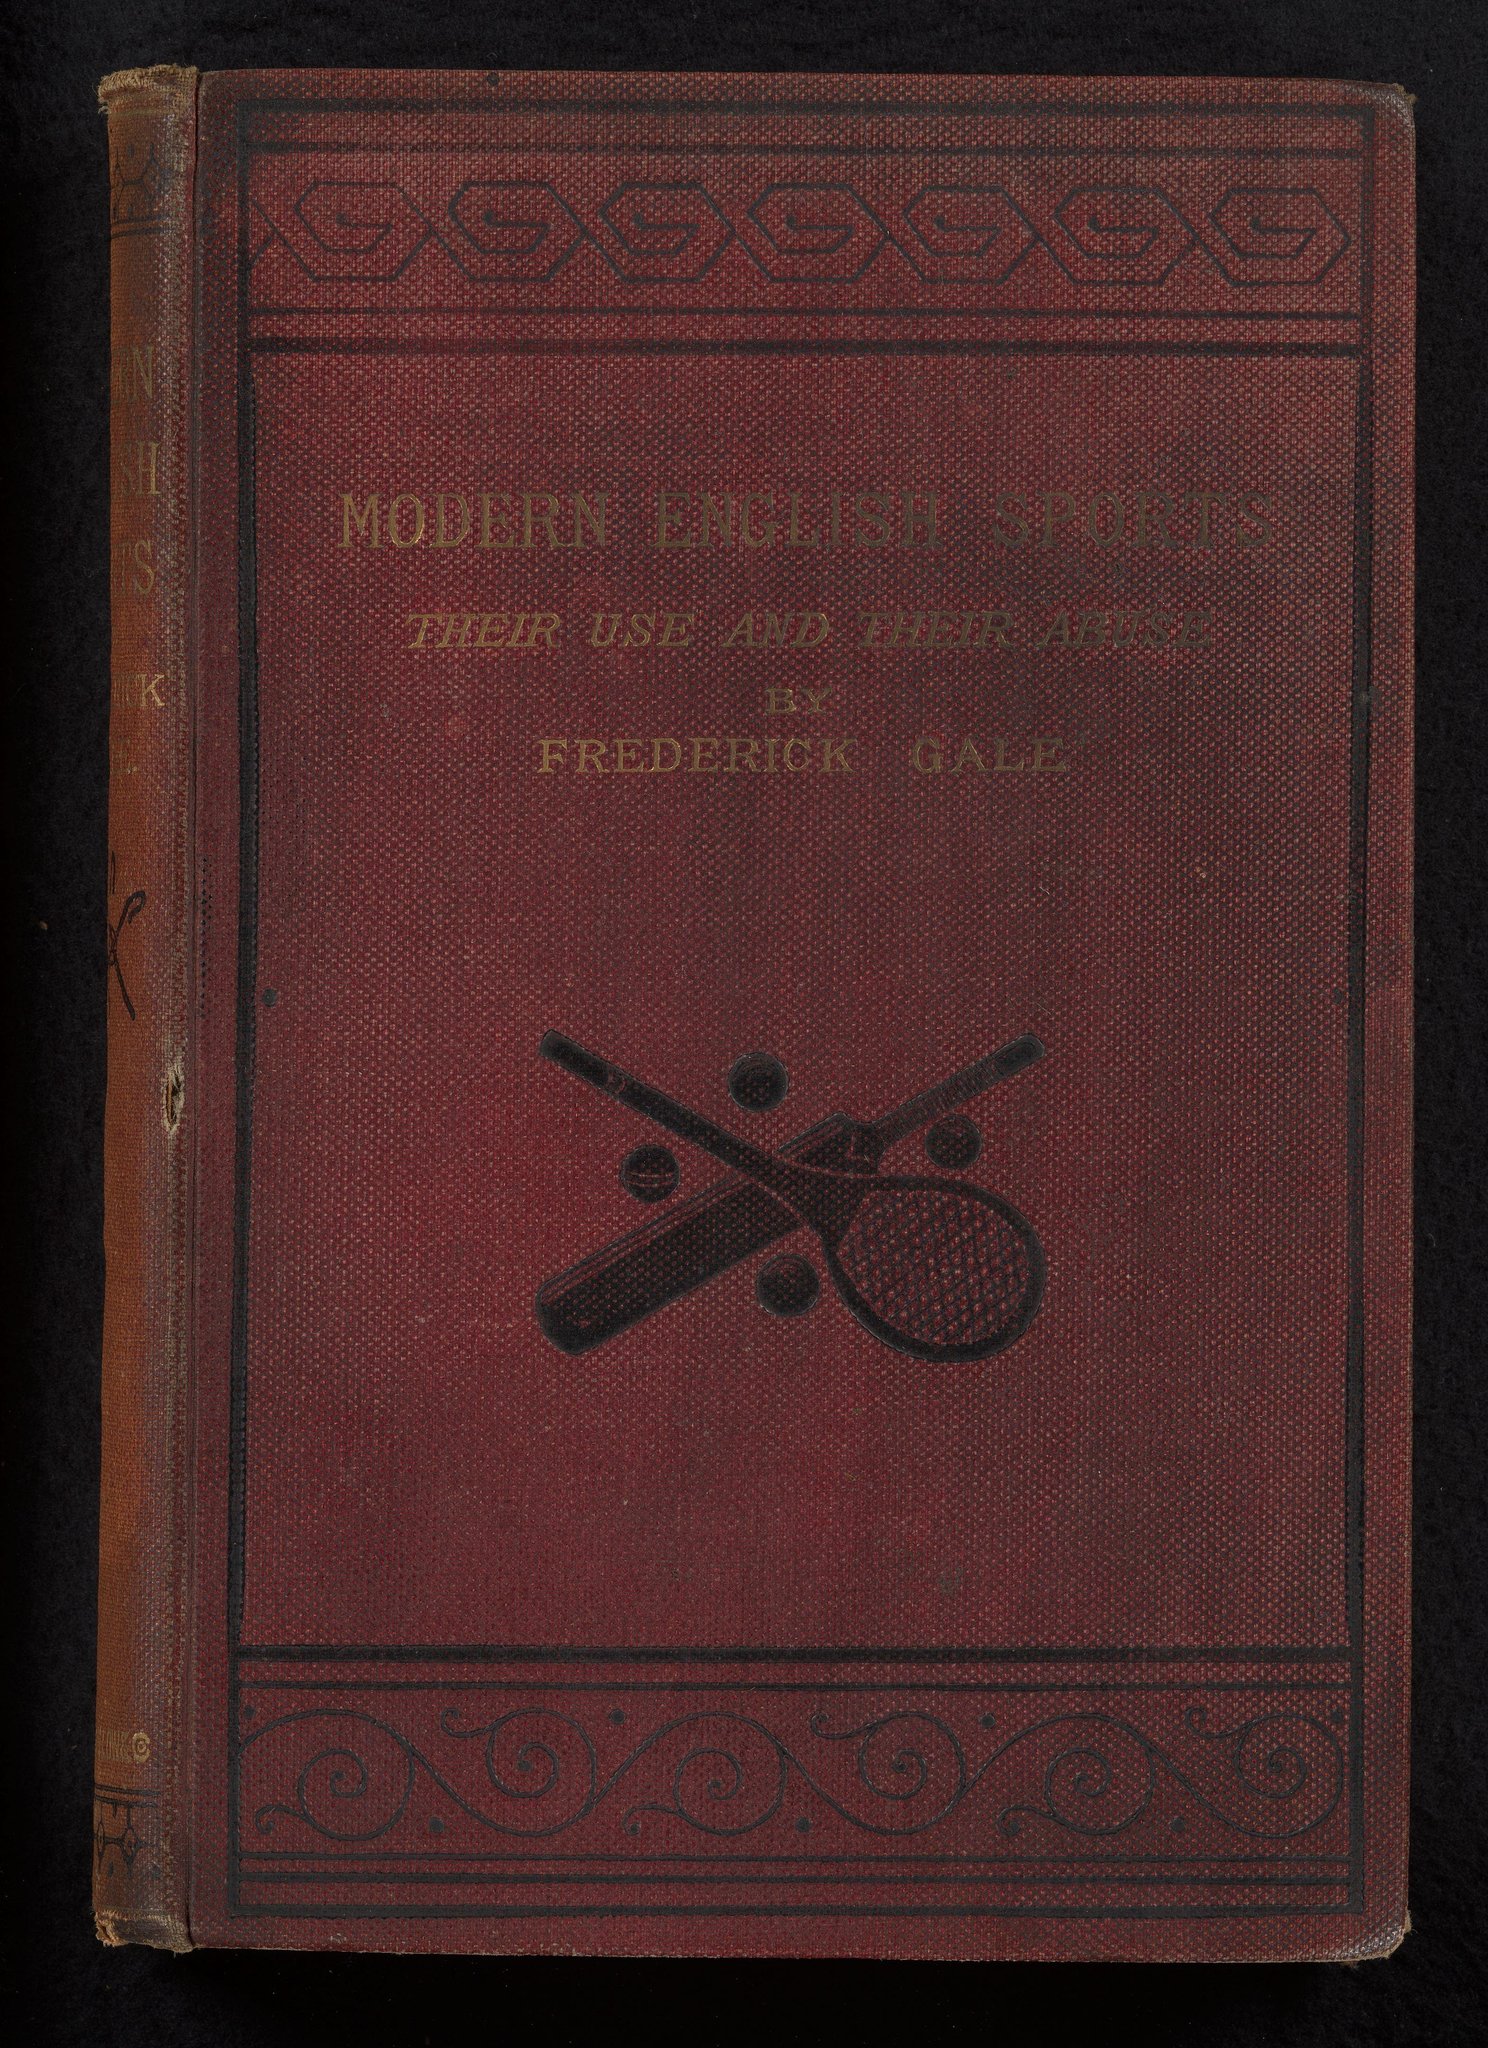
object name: book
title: Modern English sports : their use and their abuse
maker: frederick gale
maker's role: schrijver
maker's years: 1823-1904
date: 1885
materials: cardboard, linen, paper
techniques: letterpress printing, engraving, woodburytype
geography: london